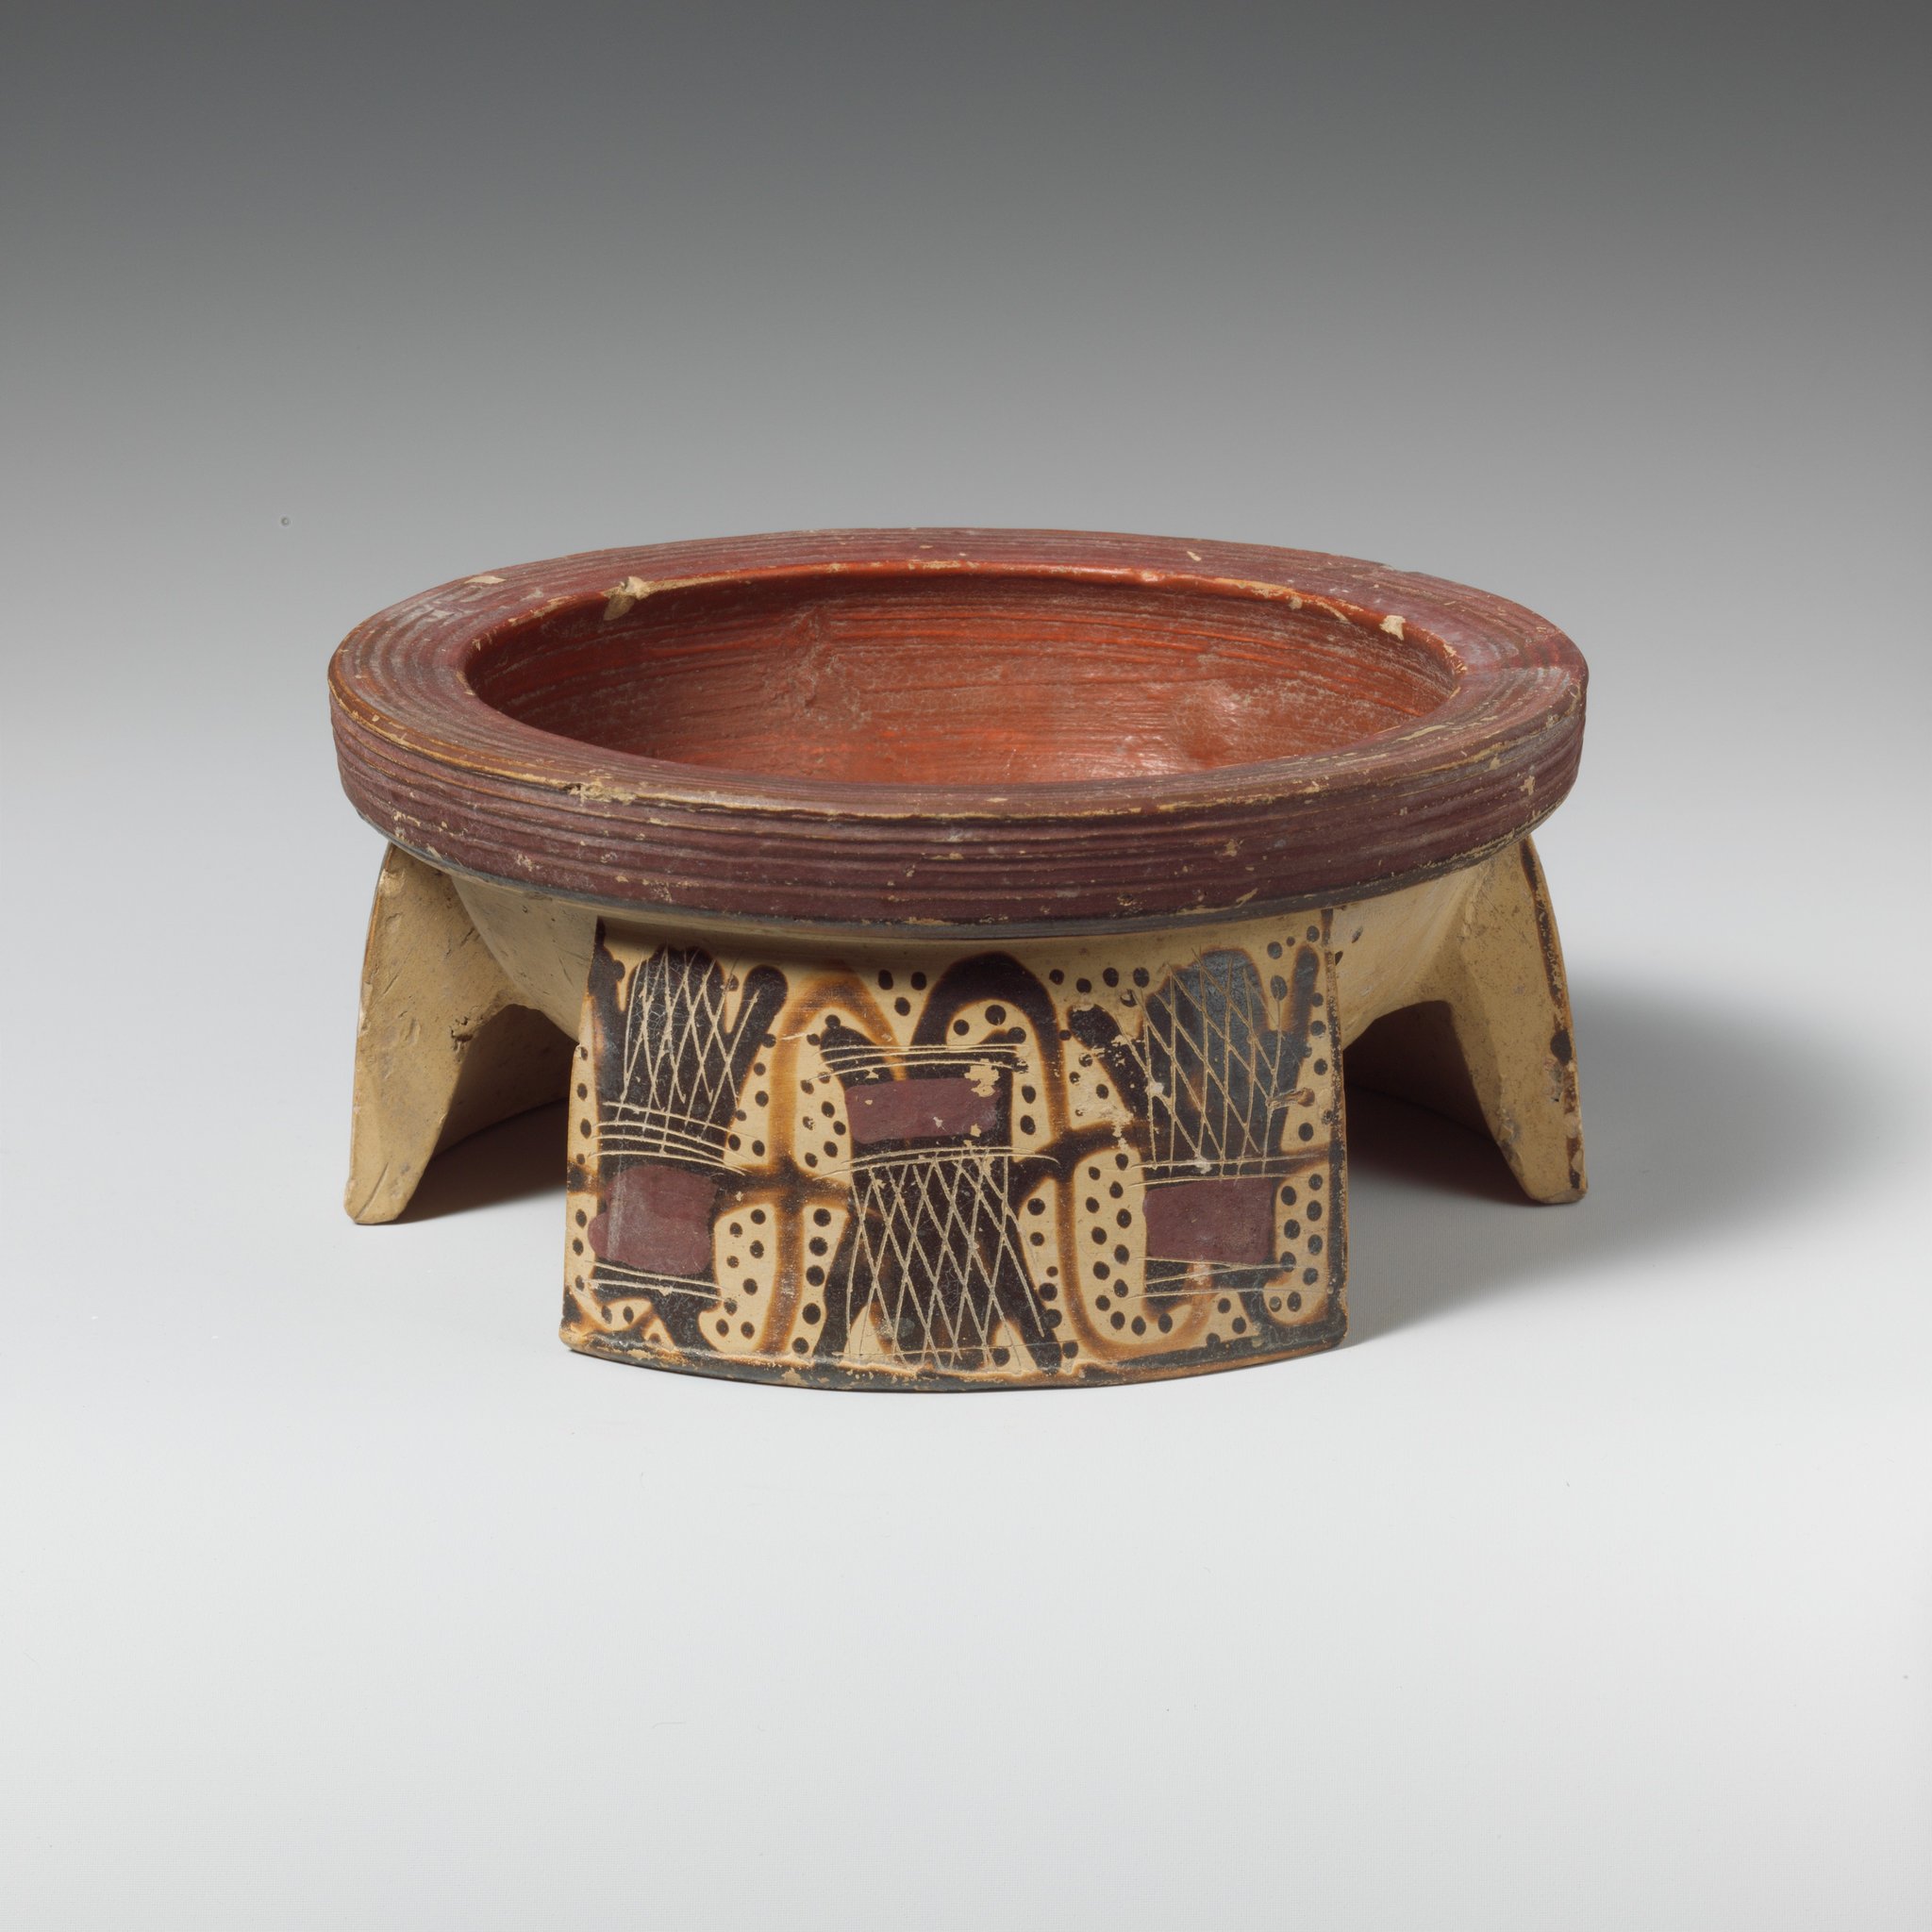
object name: tripod pyxis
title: Terracotta tripod pyxis (box)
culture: greek, corinthian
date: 550-501 BCE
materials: terracotta